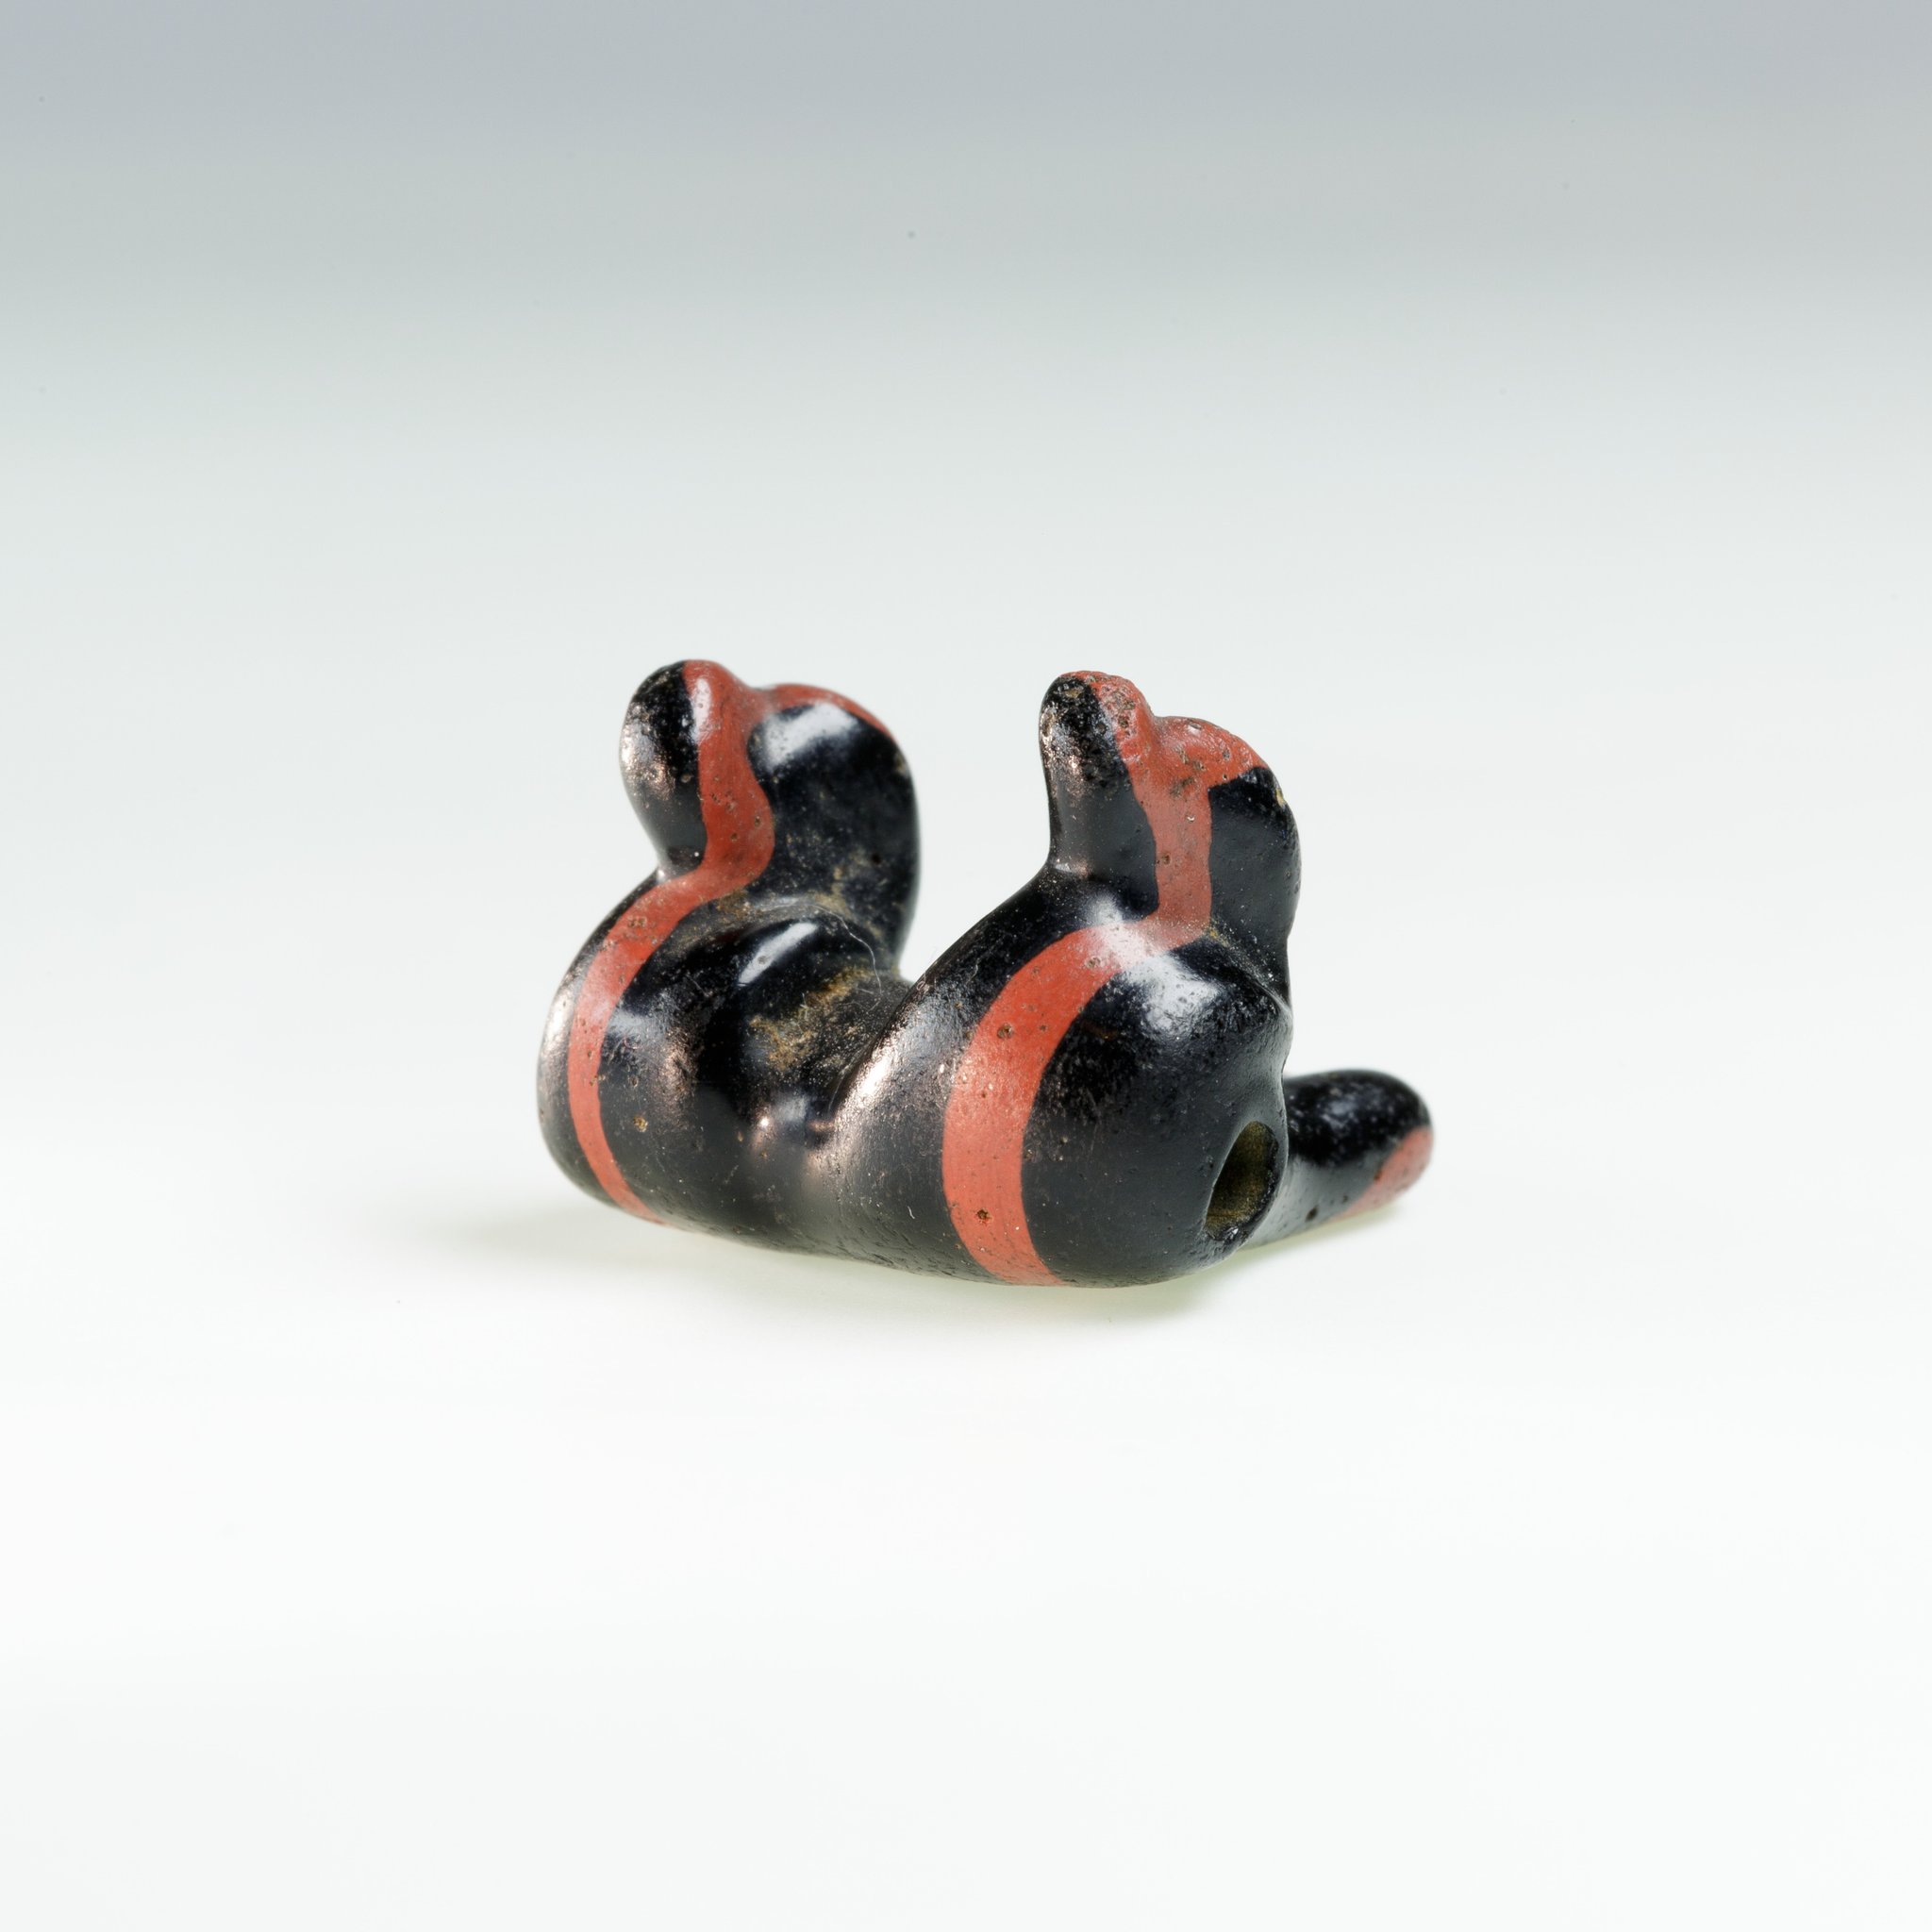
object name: pendant, ba bird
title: Pendant Depicting a Pair of Birds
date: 1390-1352 BCE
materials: glass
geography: egypt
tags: birds